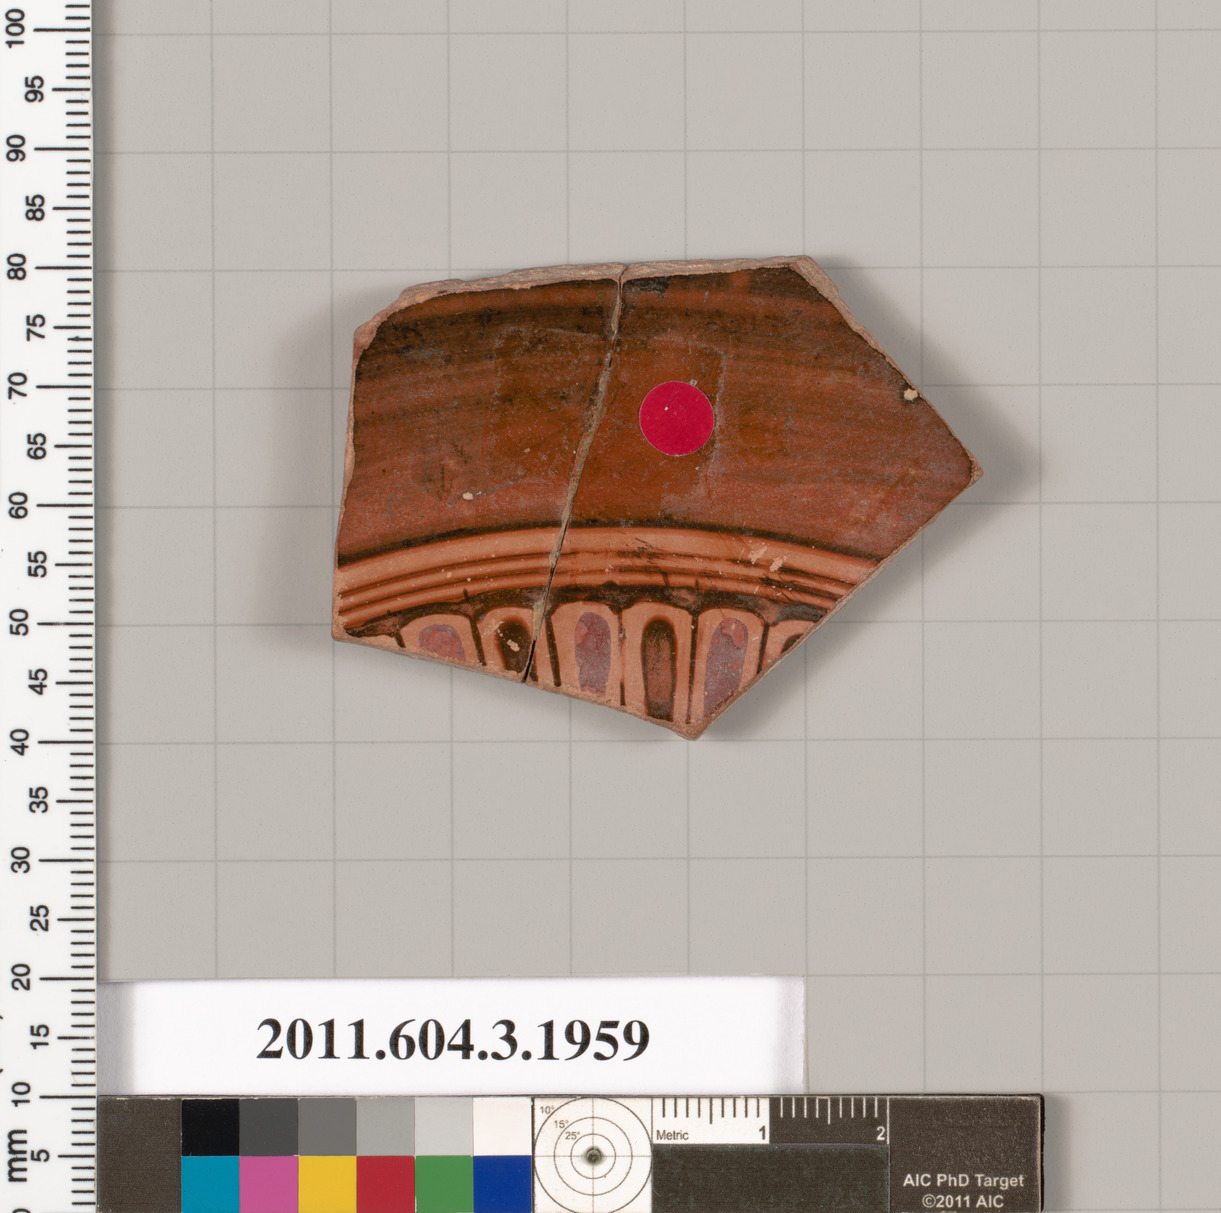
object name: kylix fragment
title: Terracotta fragment of a kylix (drinking cup)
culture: greek, attic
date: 567-535 BCE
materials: terracotta